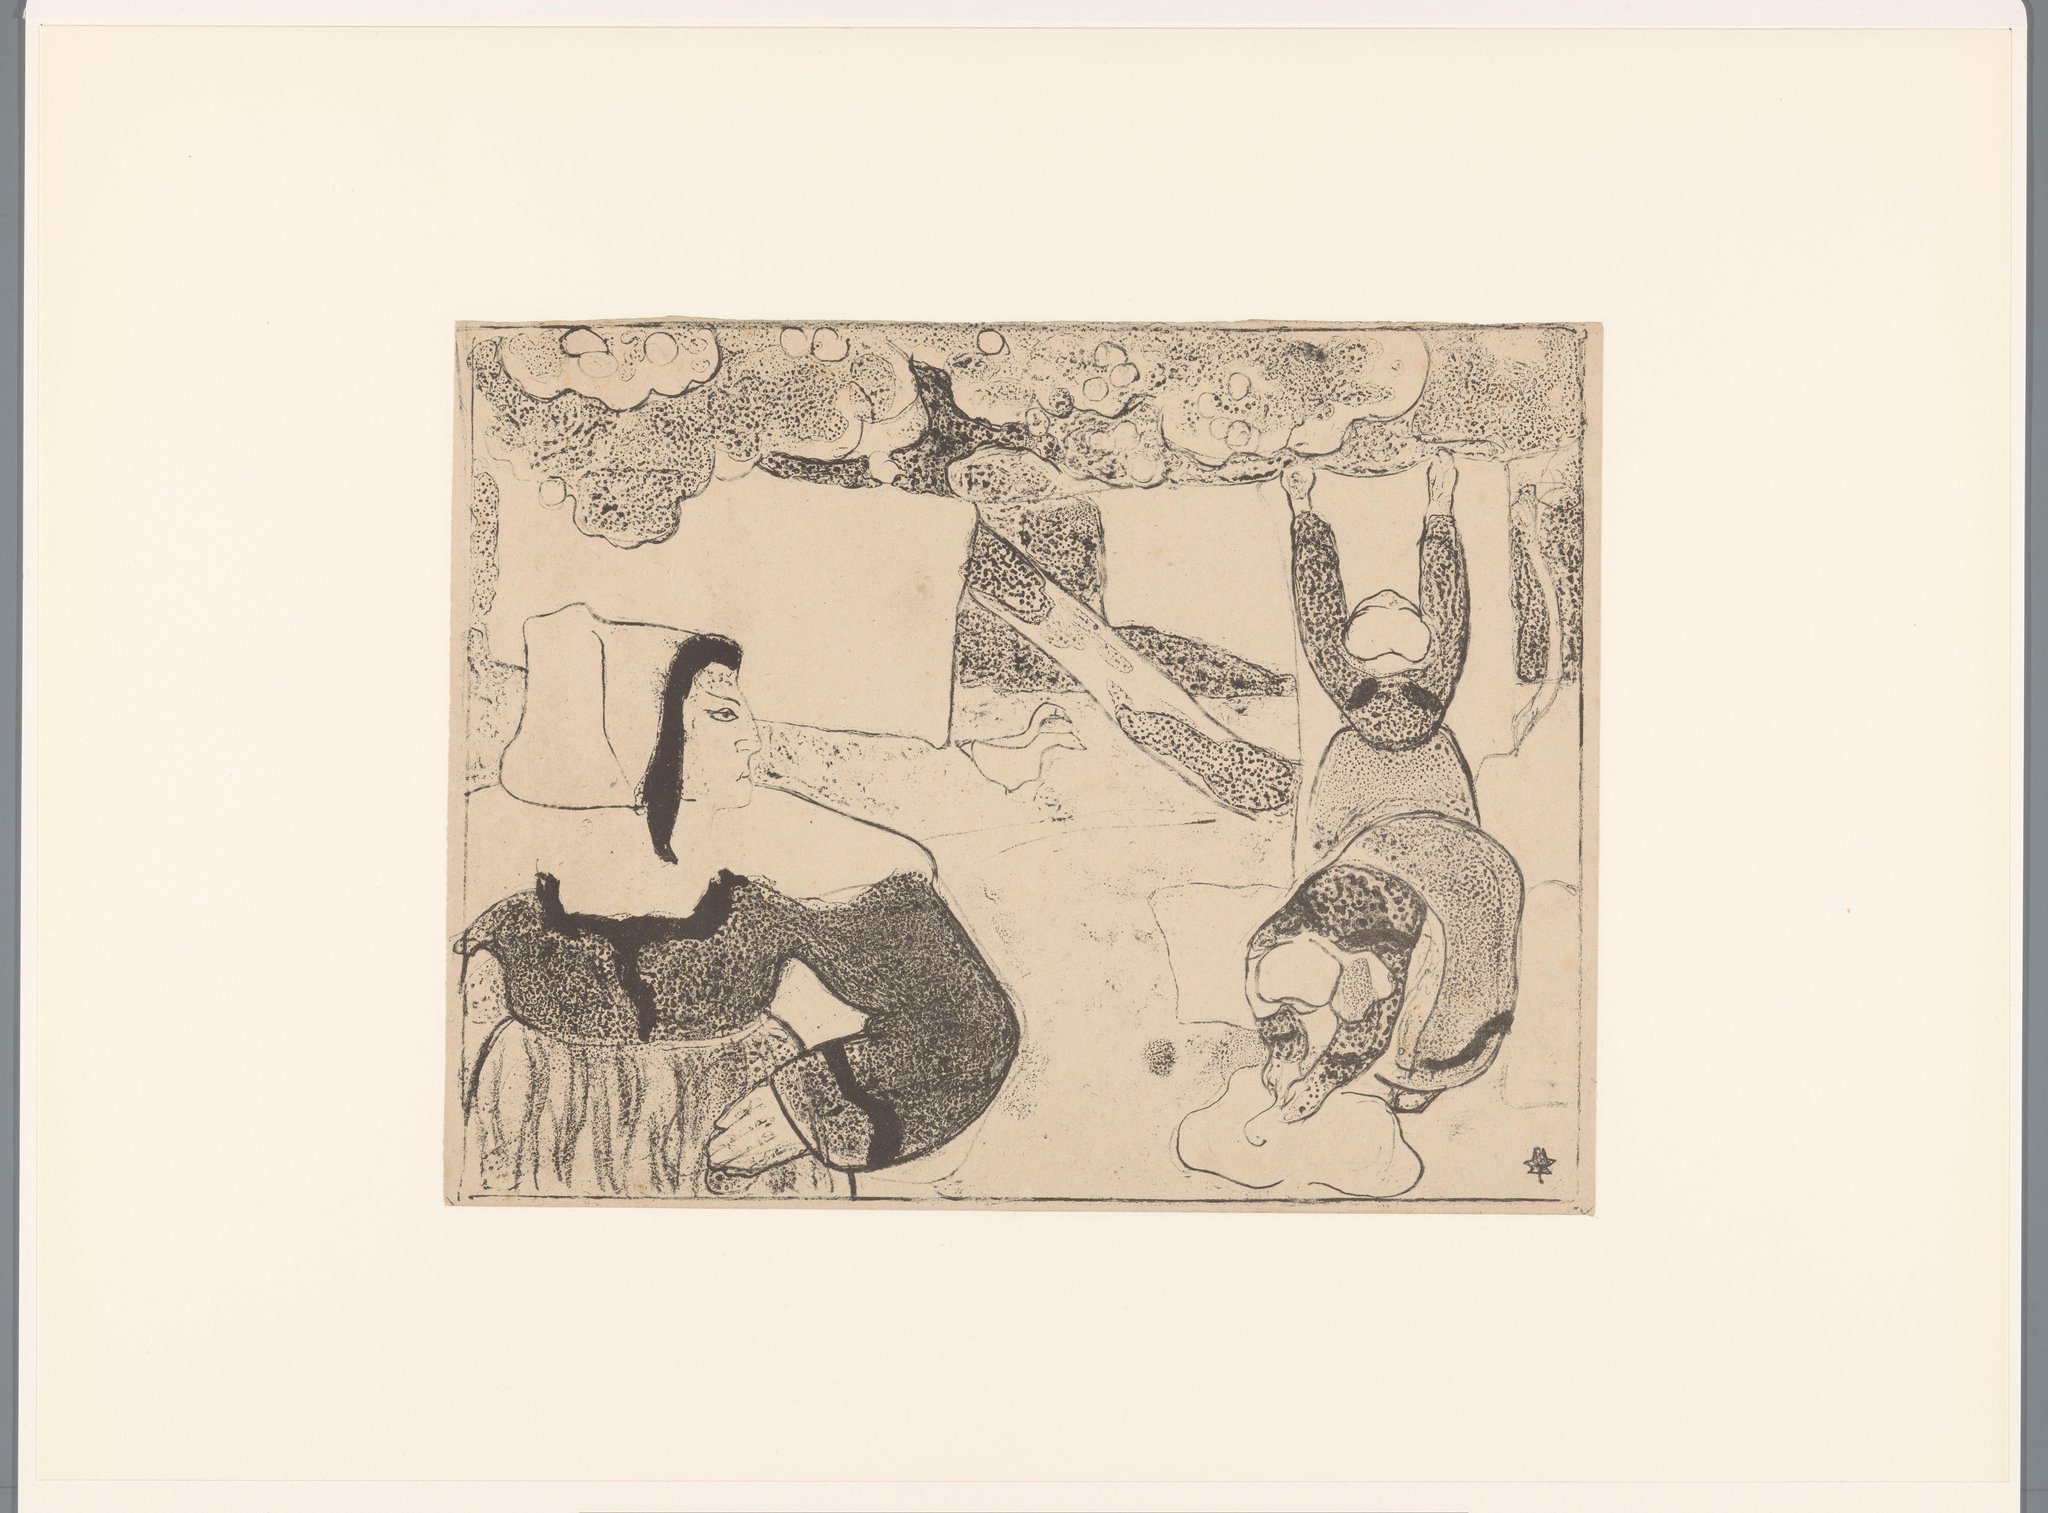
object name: print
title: Bretonneries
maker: émile bernard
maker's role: print maker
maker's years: 1868-1941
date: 1889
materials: paper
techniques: lithography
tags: fashion, clothing, farmers - aa - female farmer, farmer's wife, hanging the wash to dry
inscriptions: monogram